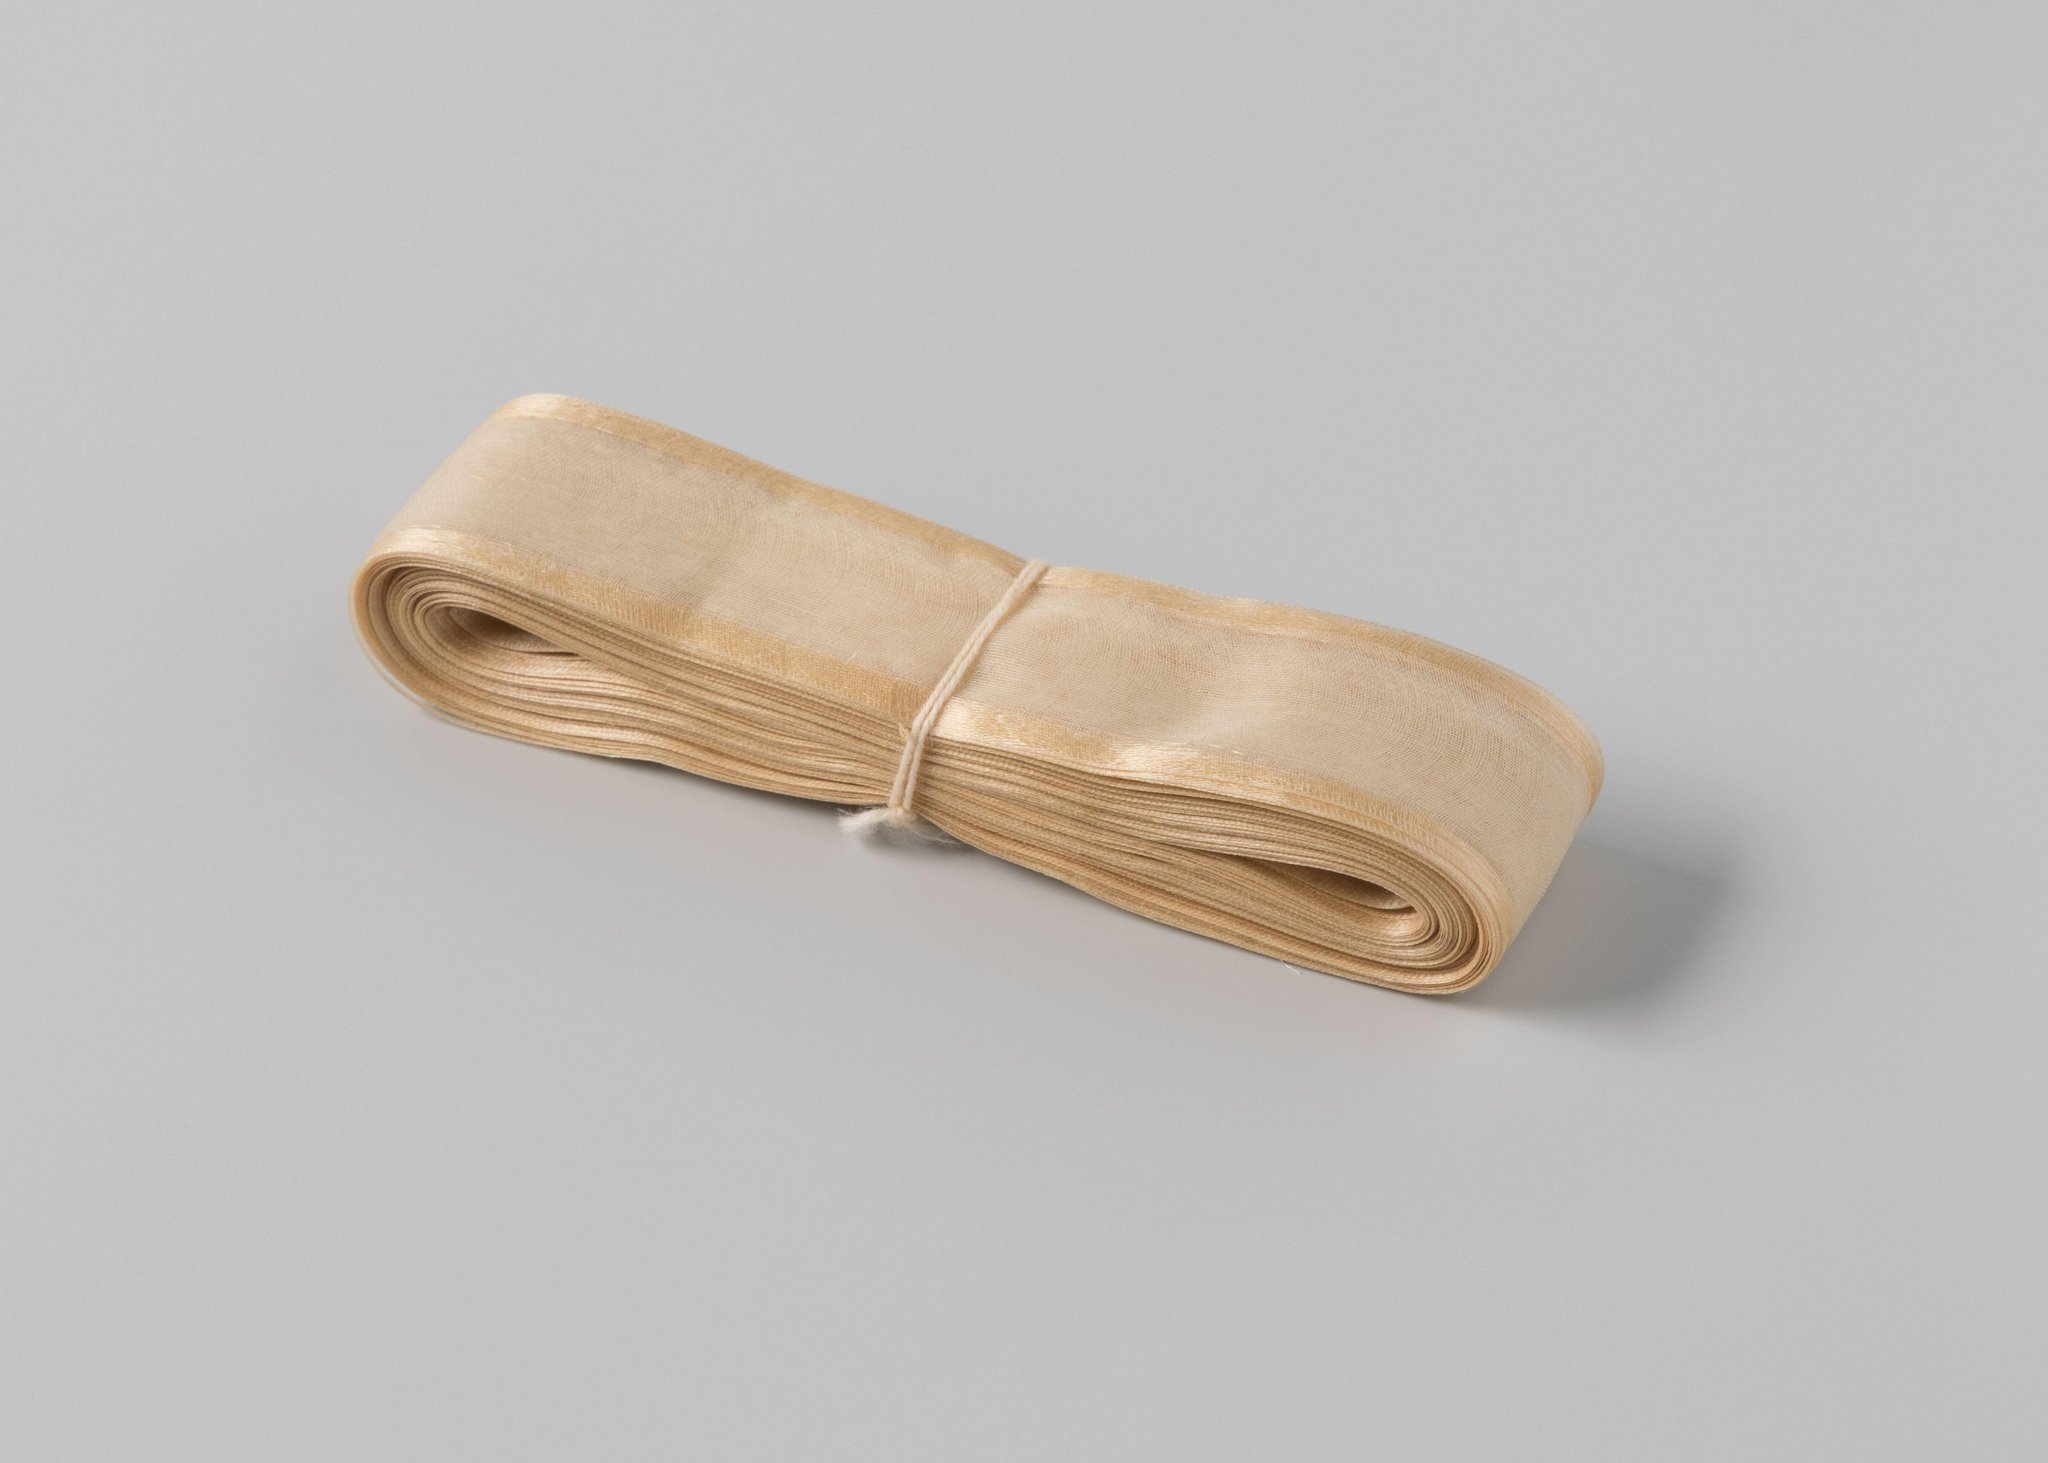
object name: ribbon material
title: Lint van crèmekleurig gaas van 15 meter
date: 1900-1915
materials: textile, silk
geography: nijmegen